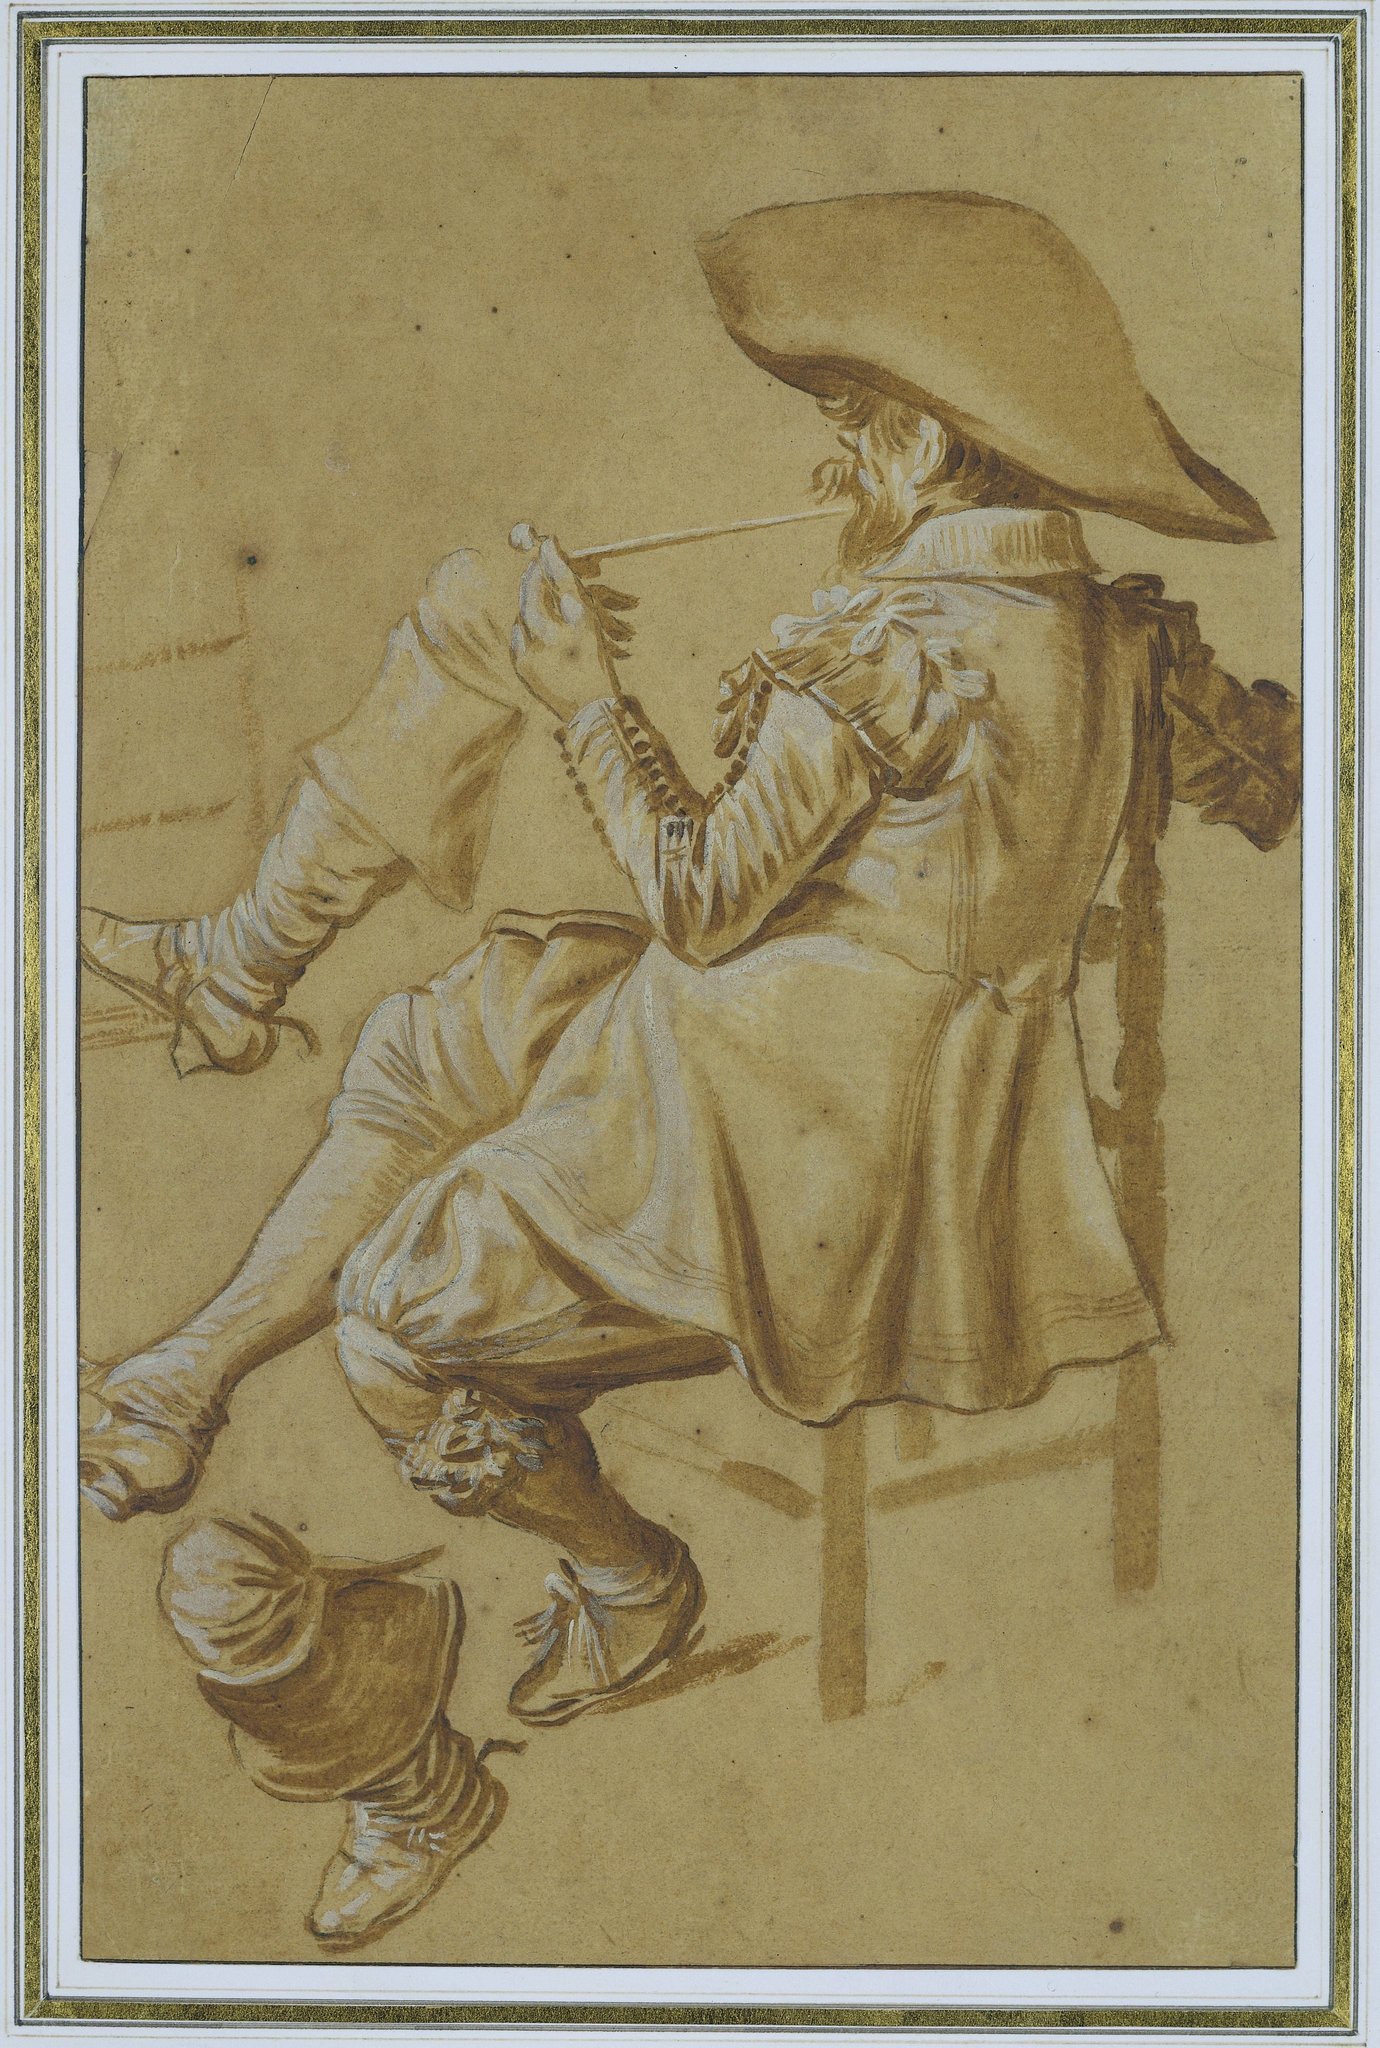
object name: drawing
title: Zittende pijproker en twee onderbenen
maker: dirck hals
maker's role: draughtsman, painter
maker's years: 1591-1656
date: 1622-1627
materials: chalk, oil, paper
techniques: brush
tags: sitting figure, pipe ~ tobacco (+ taking (particular) foodstuffs: eating, drinking, smoking, chewing, etc.)